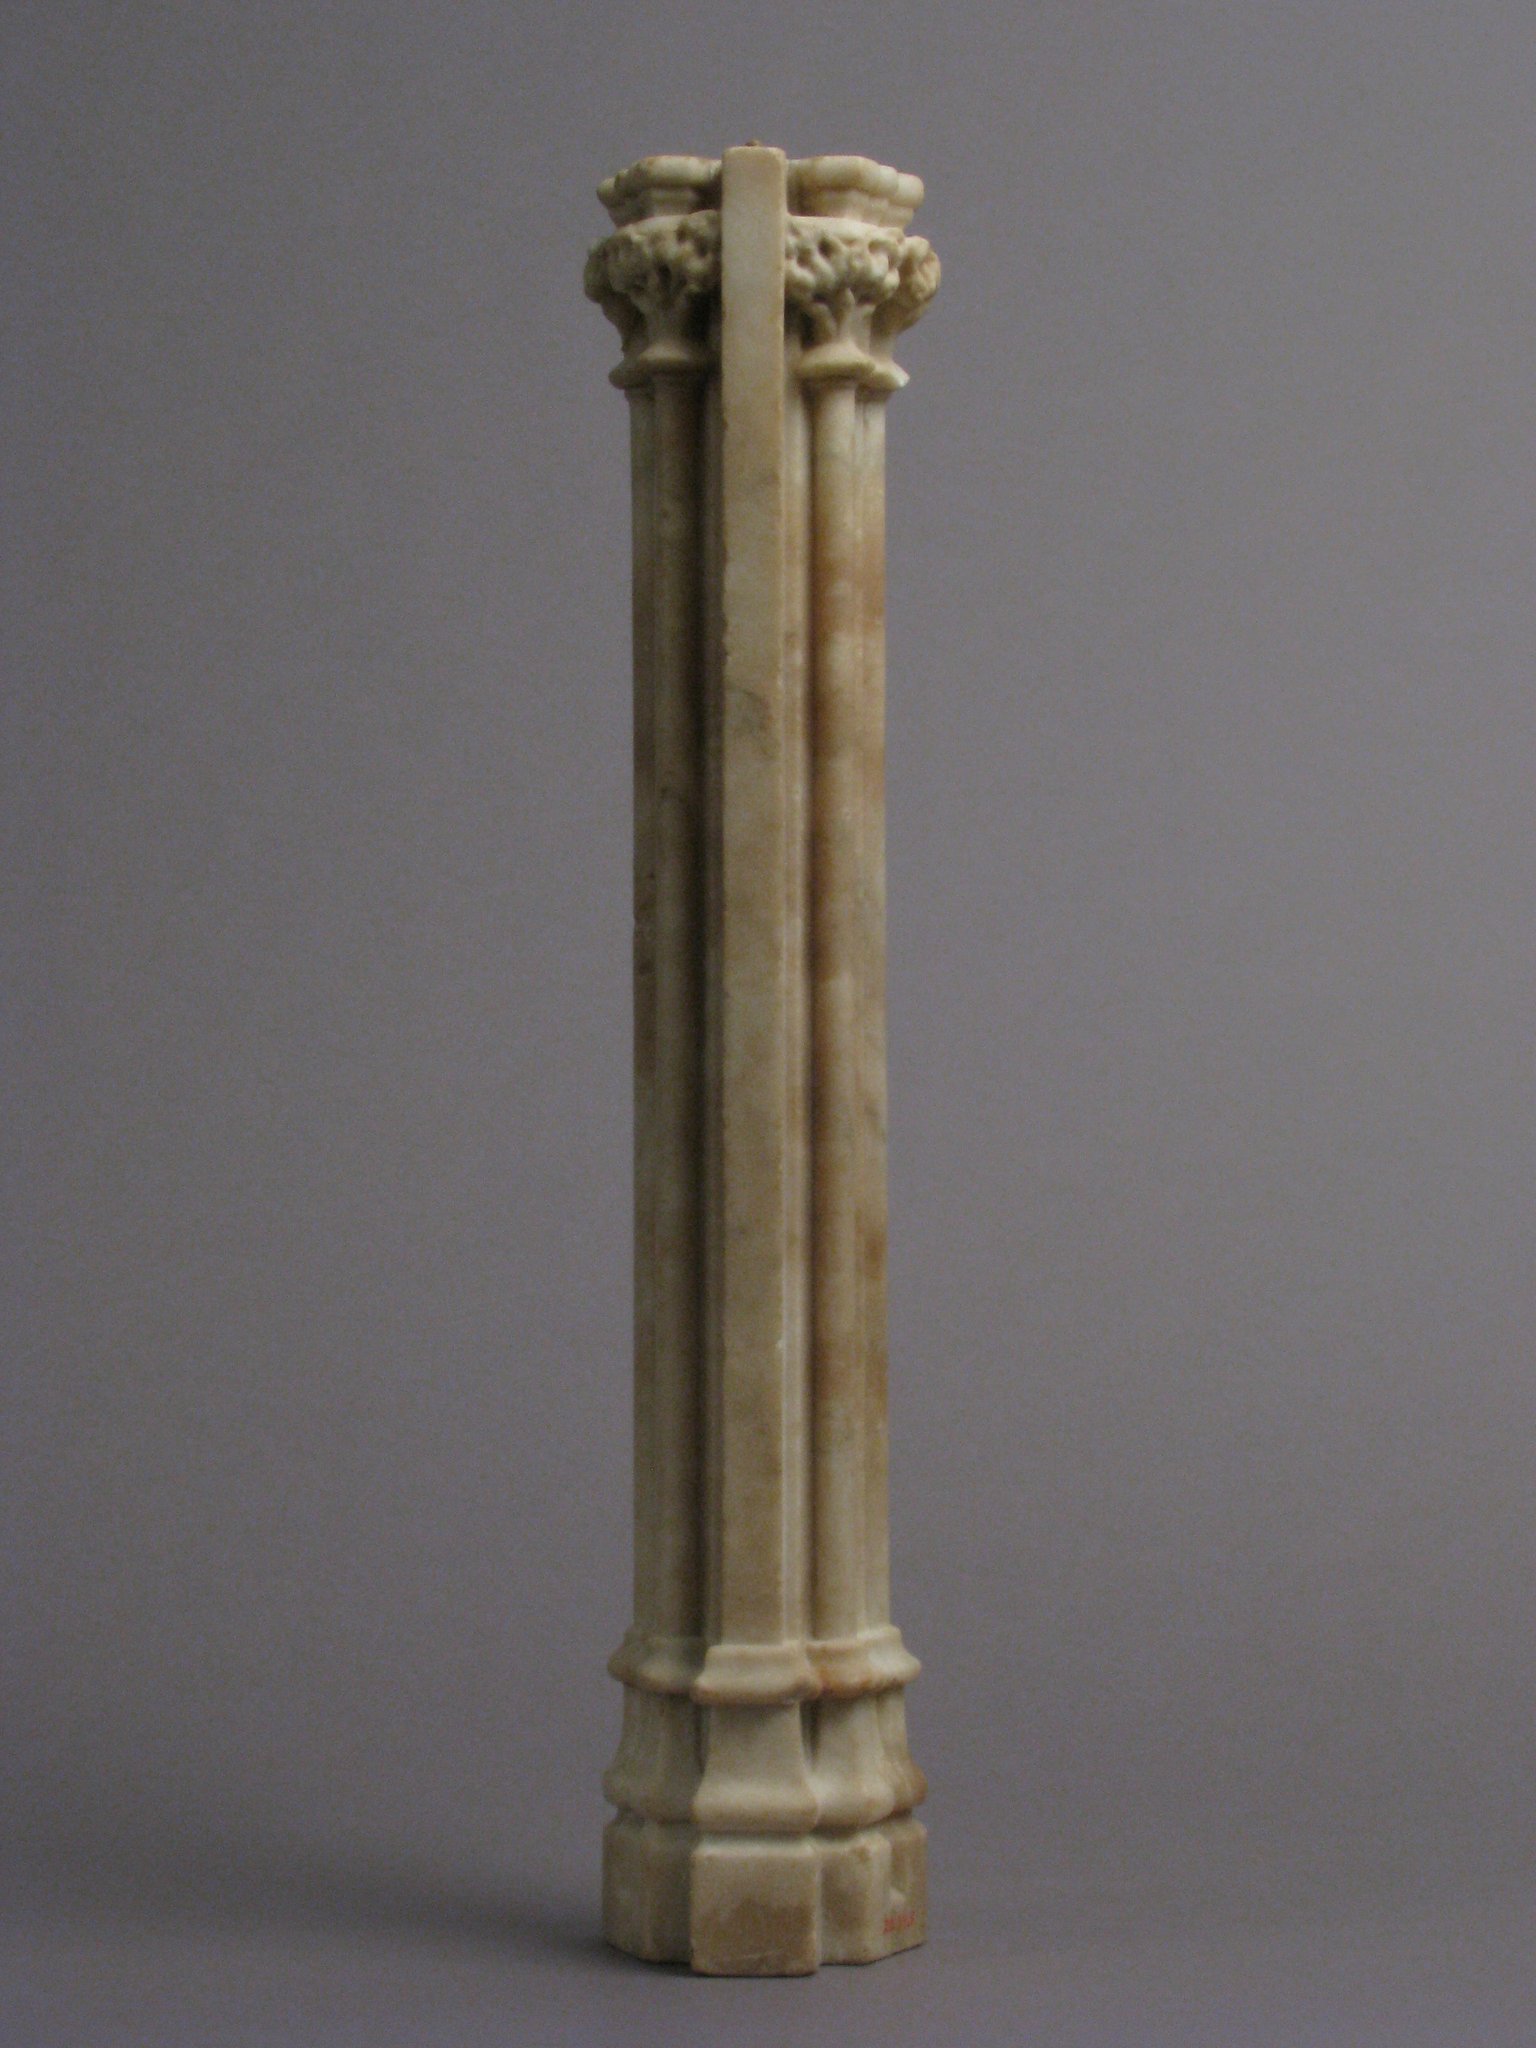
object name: relief fragment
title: Architectural Fragment from a Retable, Tabernacle, or Tomb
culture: french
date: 1400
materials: marble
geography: france